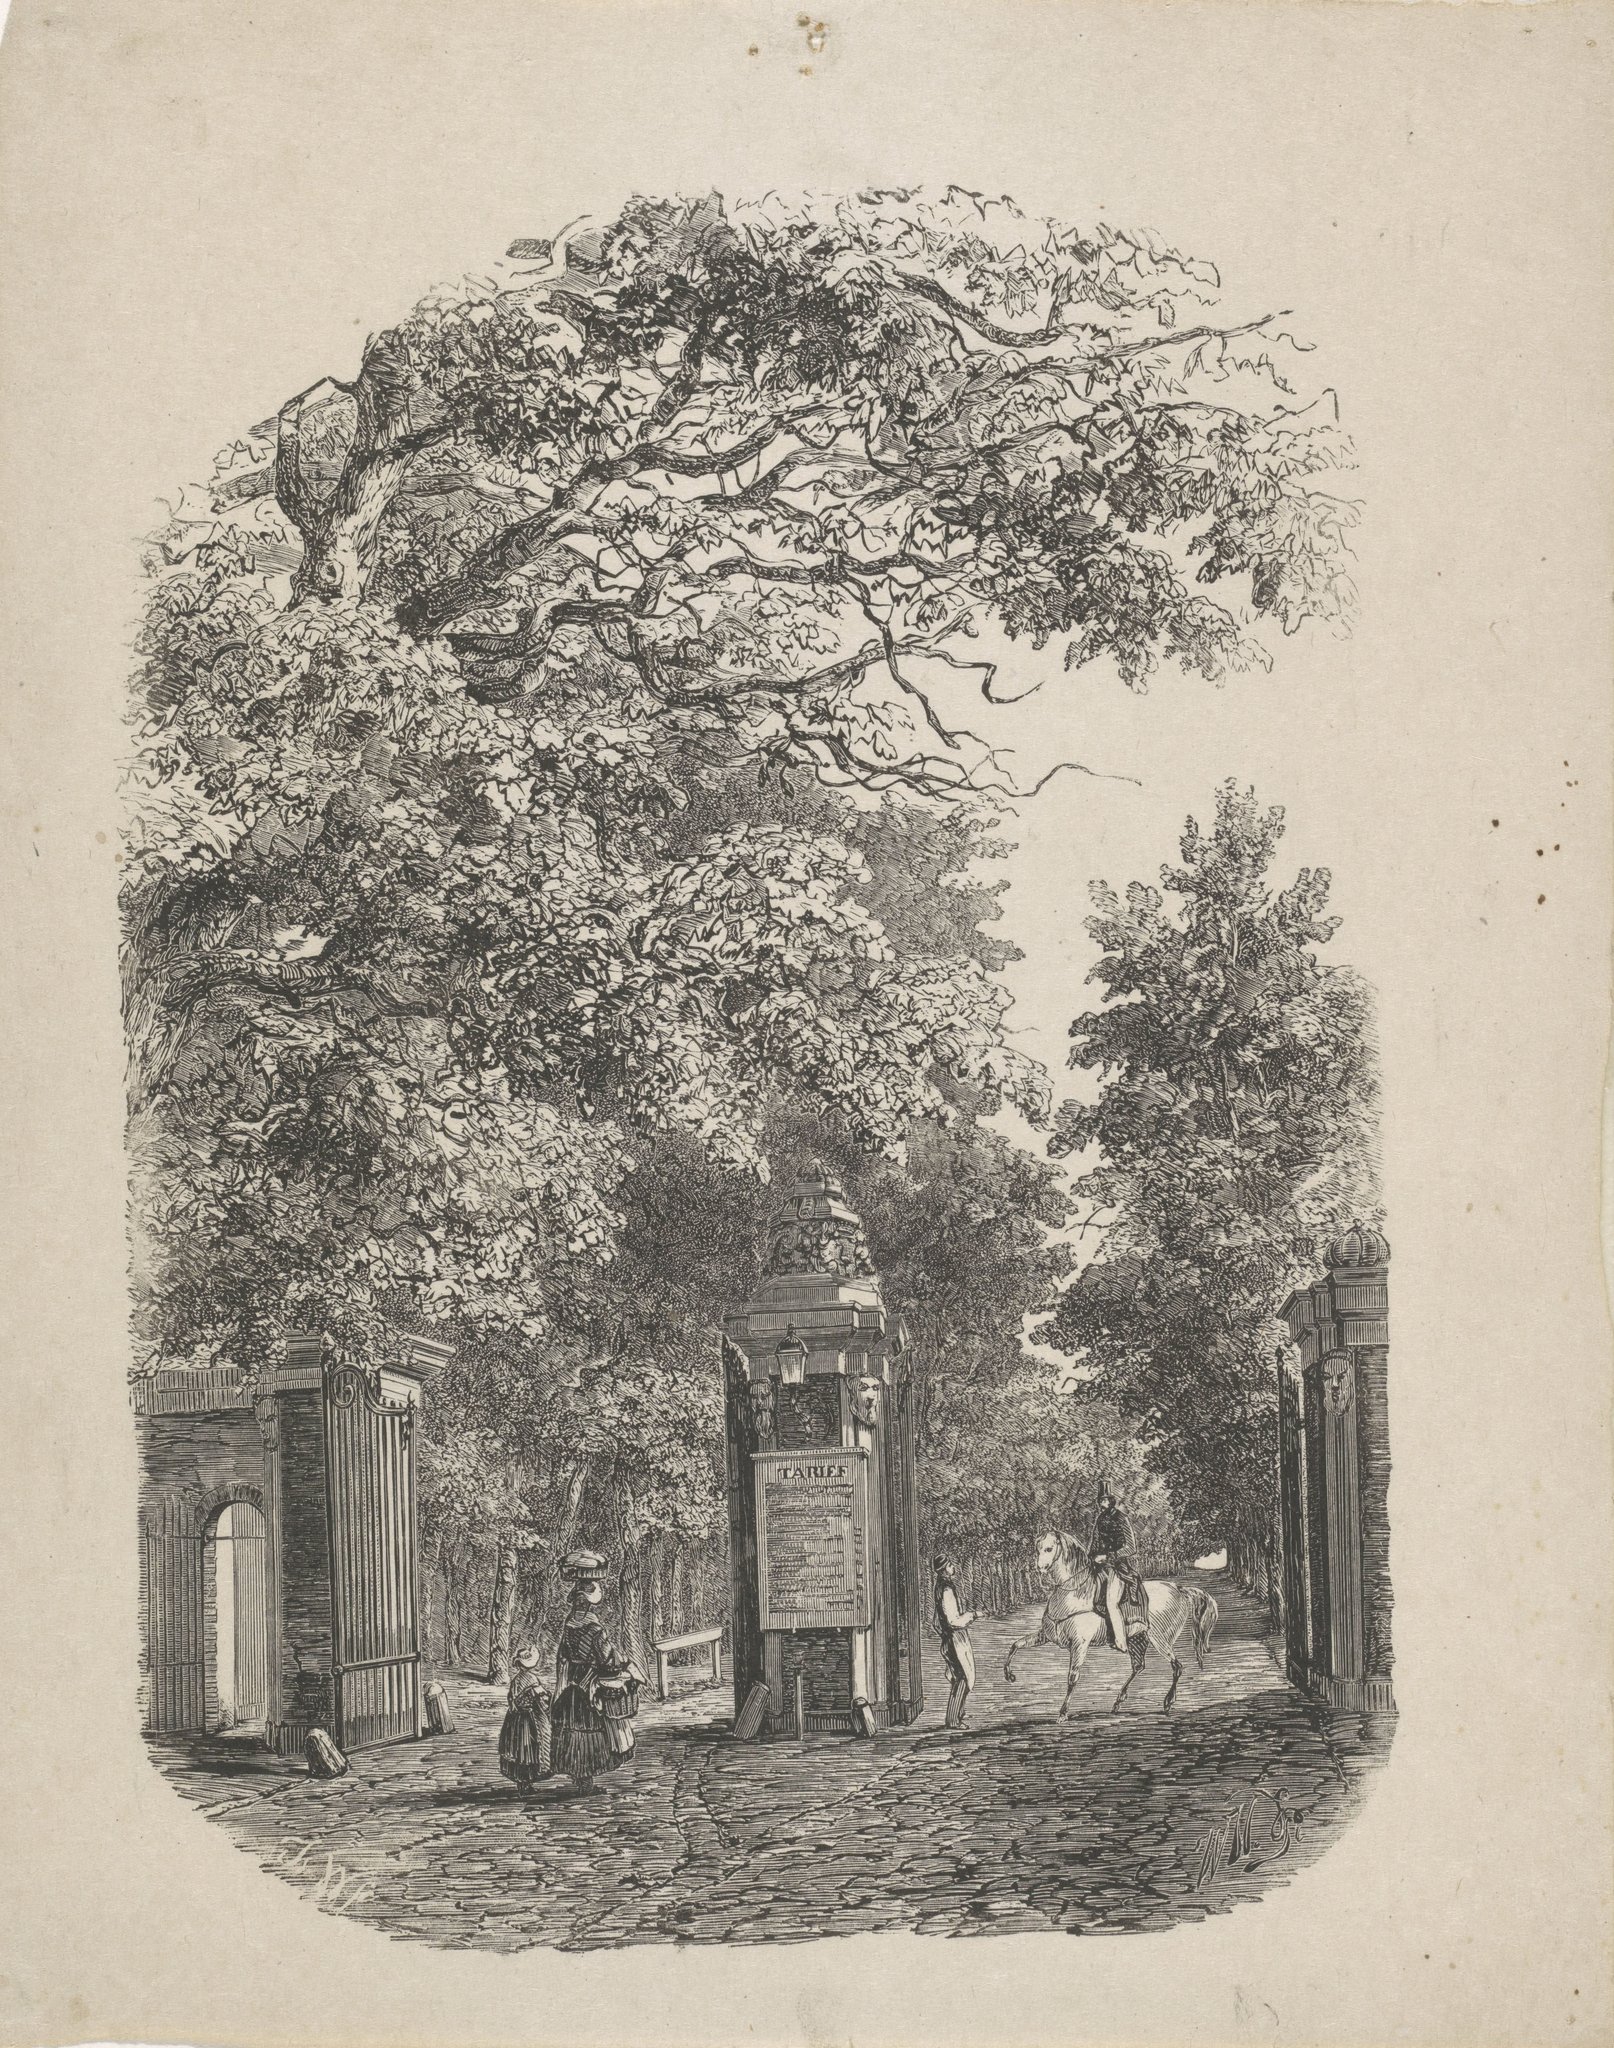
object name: print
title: Figuren bij een toegangspoort met daarop een lijst met de tarieven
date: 1836-1912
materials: paper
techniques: engraving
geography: netherlands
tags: adult man, gate, entrance, horse, mother and child(ren), woman and child(ren) (family group)